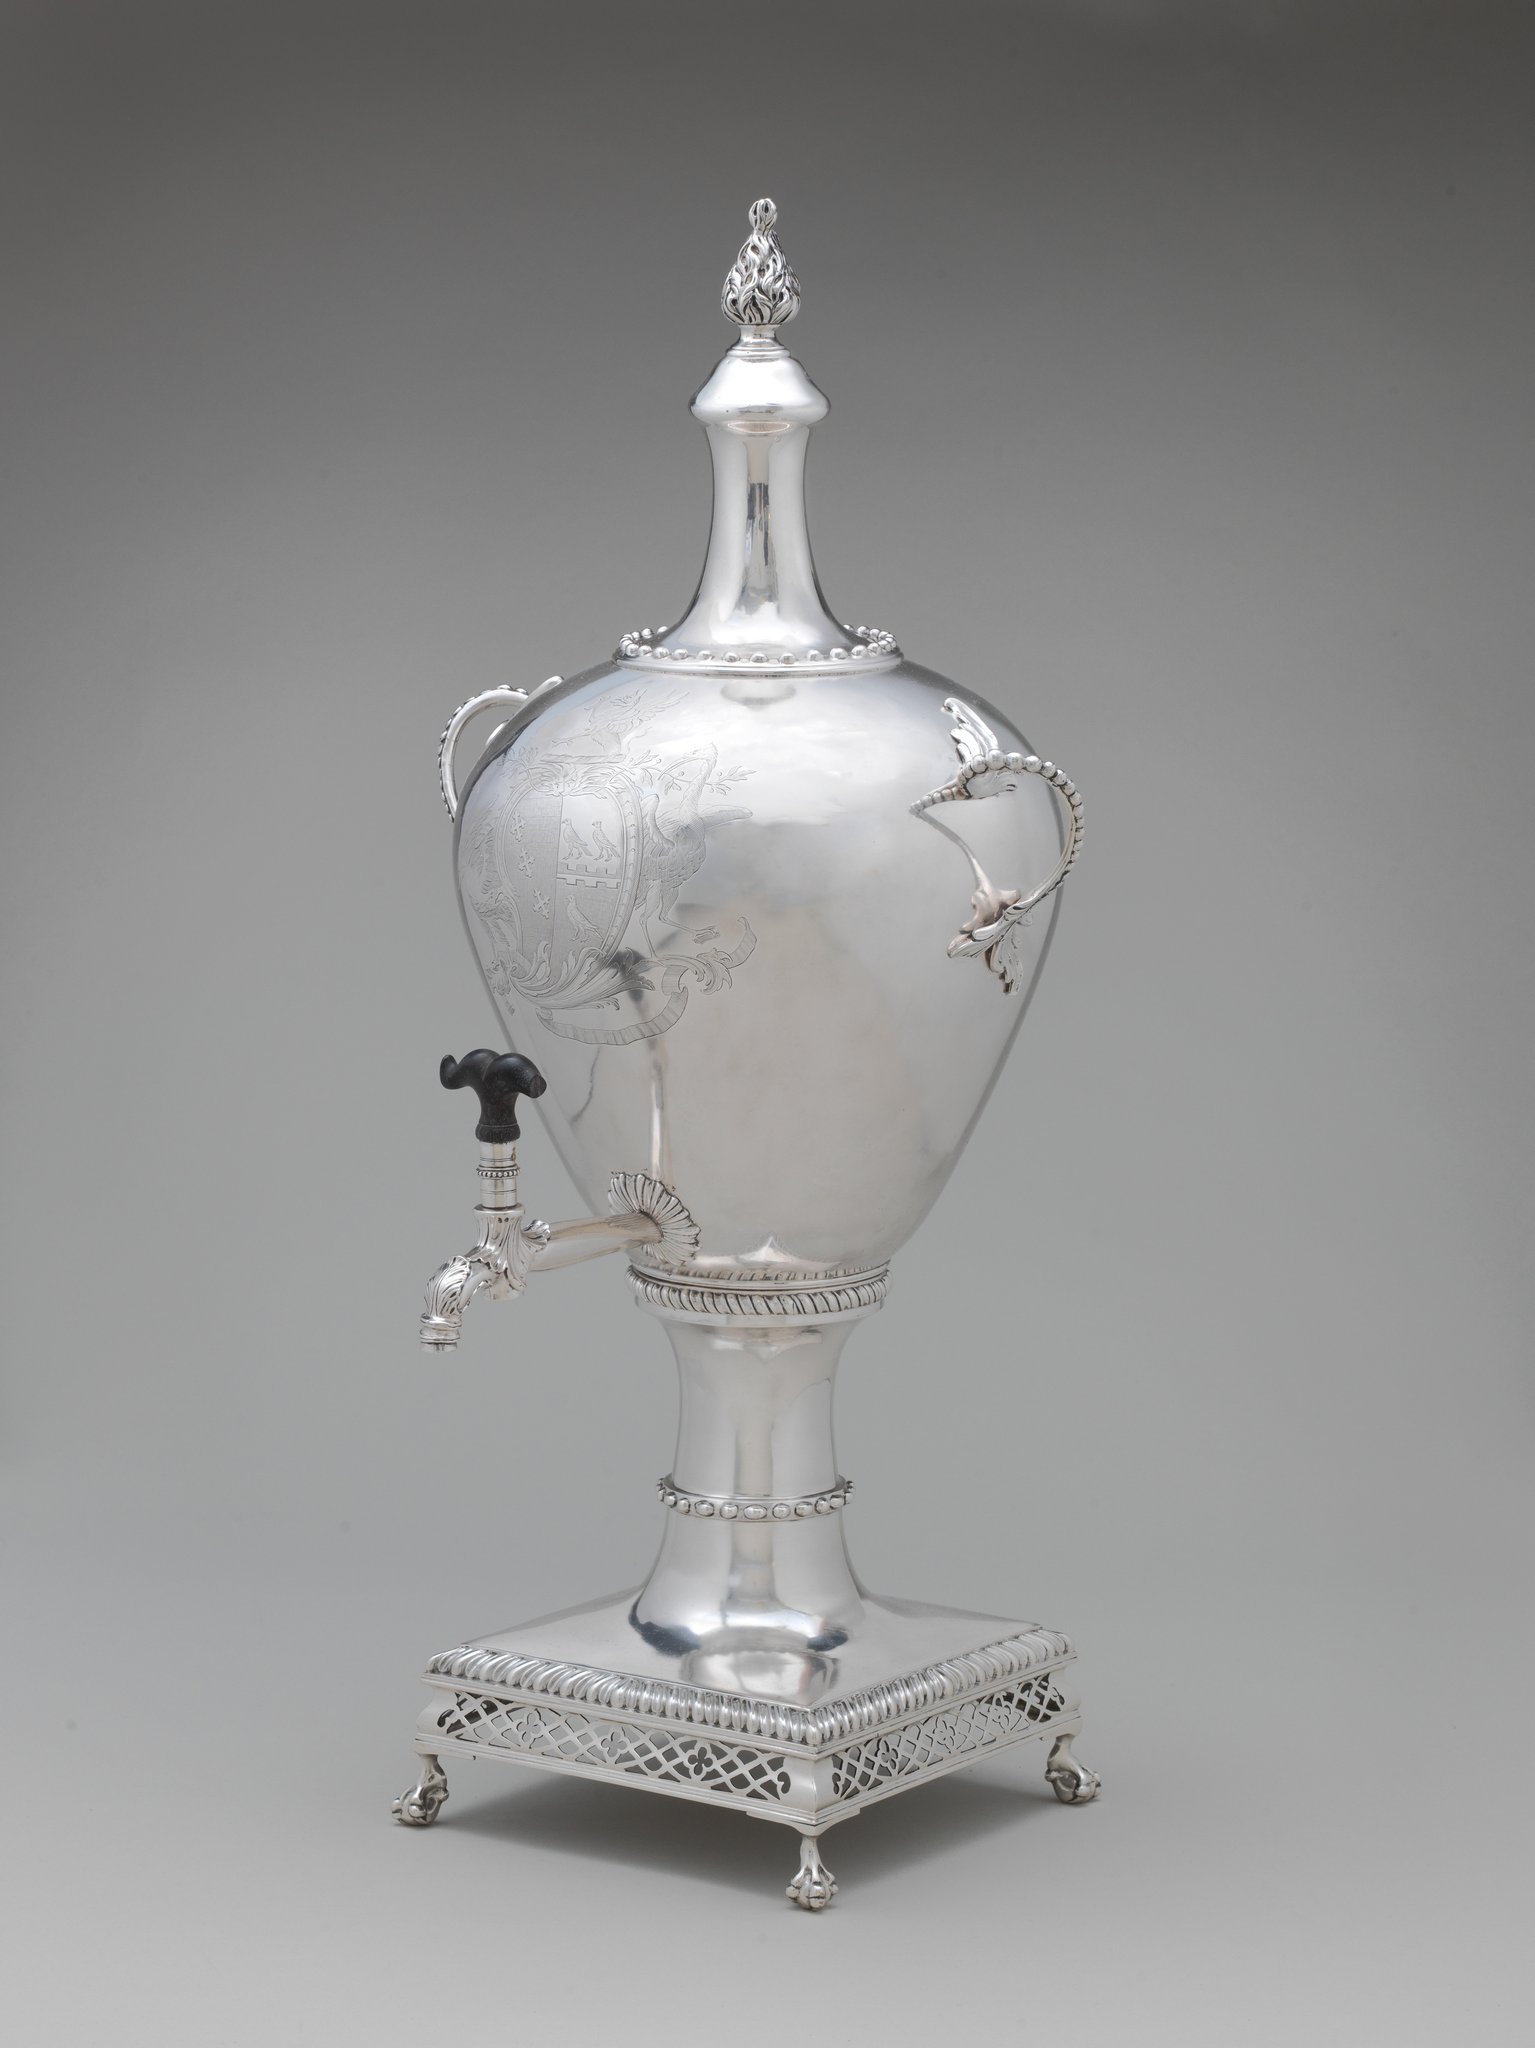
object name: hot water urn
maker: john baxter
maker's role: maker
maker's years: 1770-1773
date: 1769-1770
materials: silver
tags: coat of arms